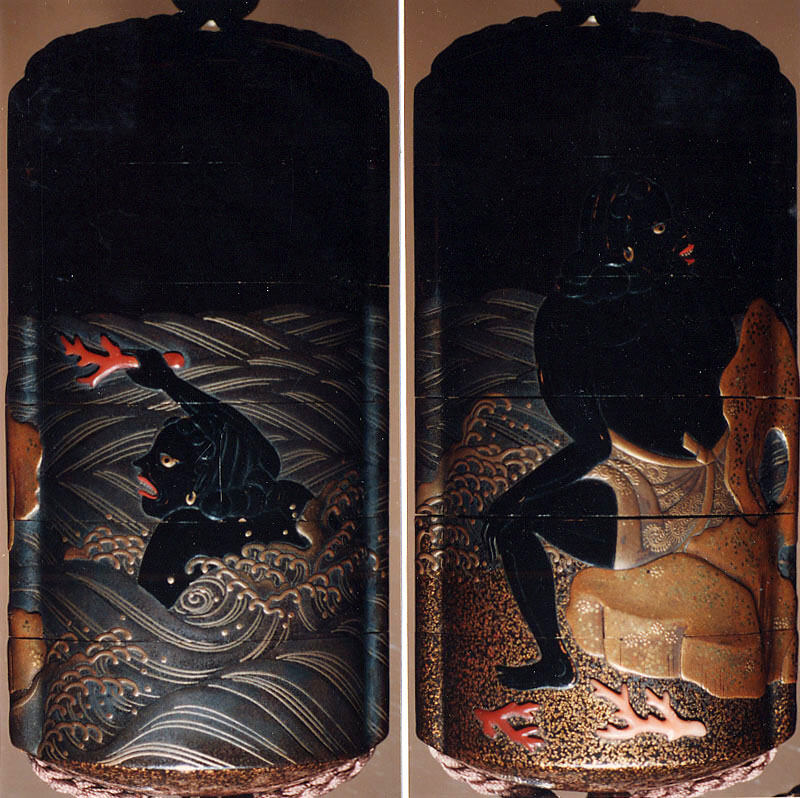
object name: inrō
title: Case (Inrō) with Design of South Sea Islander Diving for Coral (obverse); South Sea Islander Seated on Rock beside Water (reverse)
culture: japanese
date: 1801-1900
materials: coral, gold, lacquer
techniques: fundame, hiramakie, roiro, maki-e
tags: human figures,waves